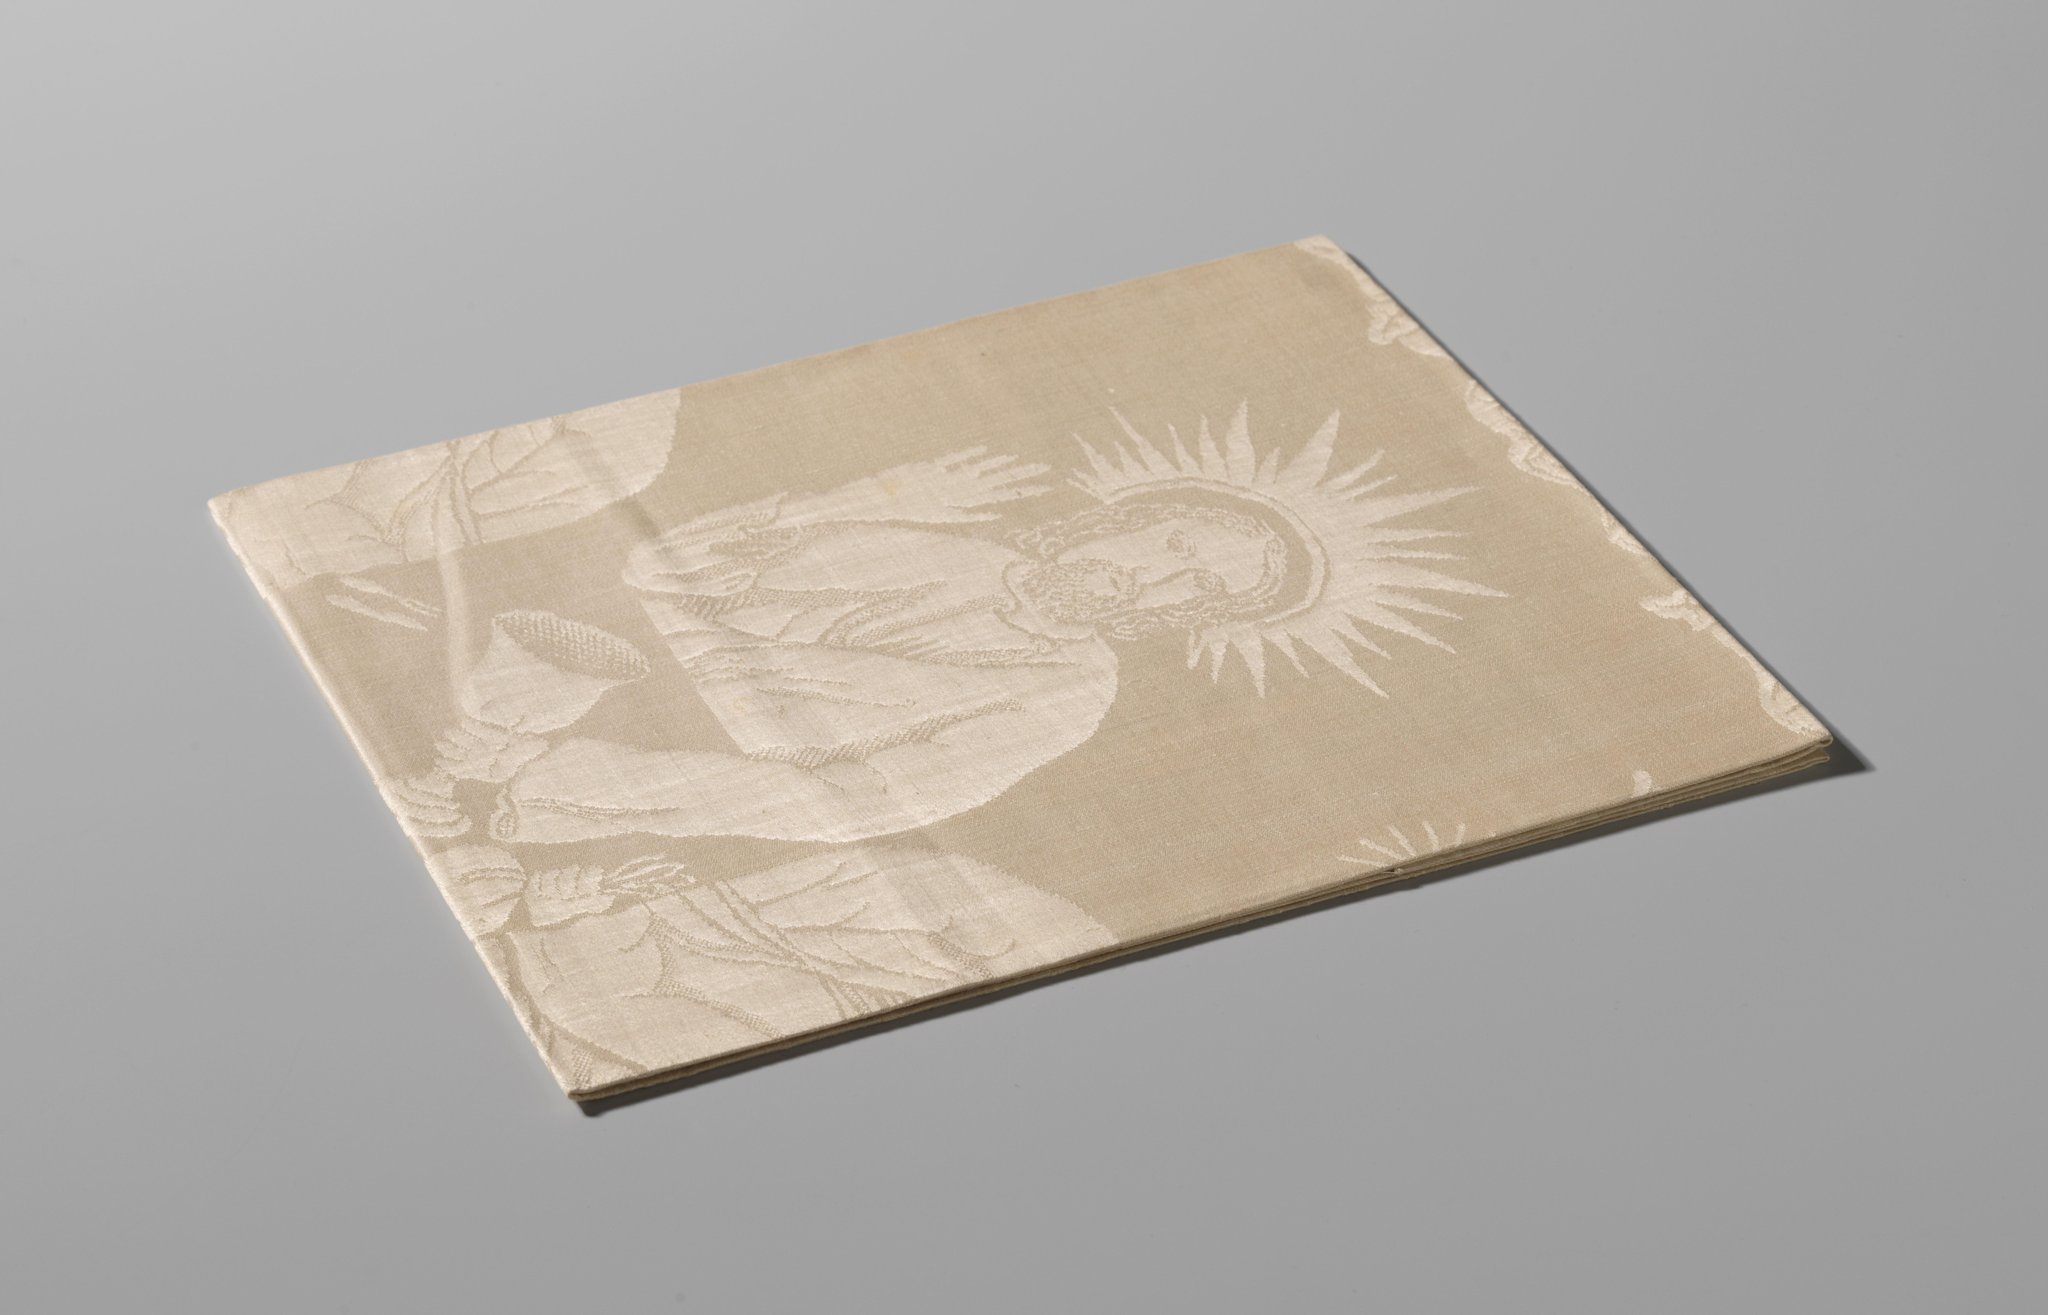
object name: napkin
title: Servet van wit linnendamast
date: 1859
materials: linen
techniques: damask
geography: borne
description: Wit linnen damasten servet met een voorstelling van het Laatste Avondmaal.